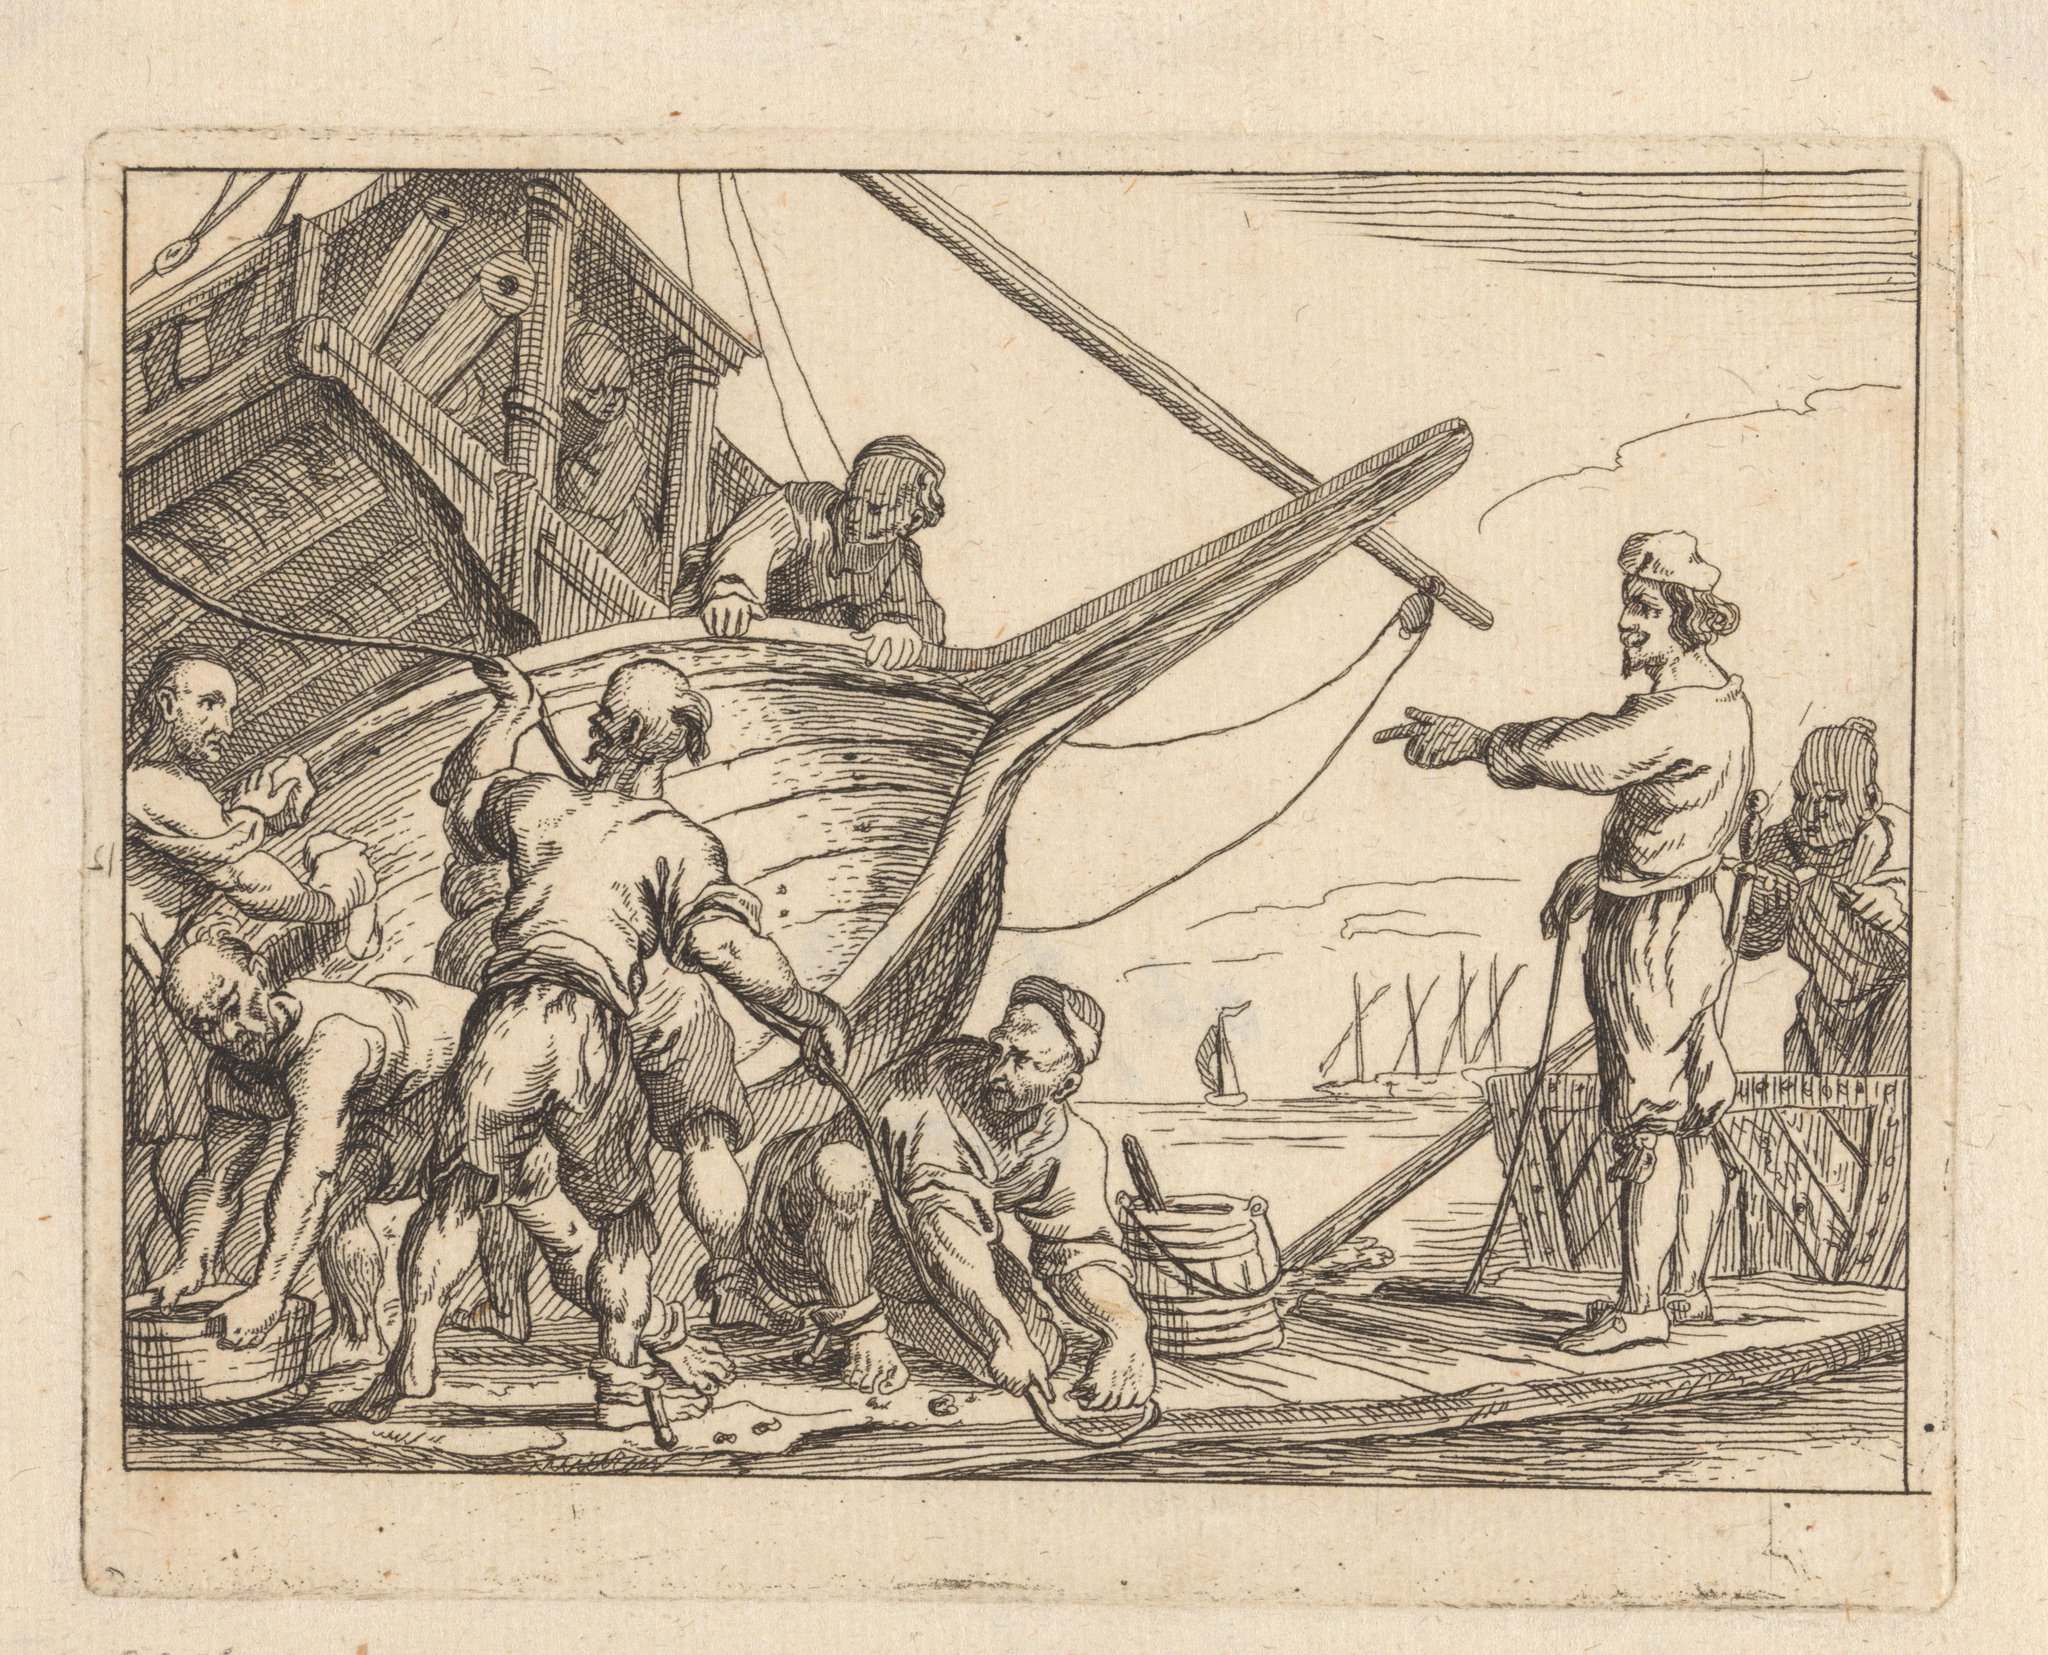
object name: print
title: Slaven aan het werk bij een schip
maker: m. schaep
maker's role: print maker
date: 1649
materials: paper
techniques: etching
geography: genoa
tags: harbour, trireme, galley (+ view ~ vehicle, ship, etc.), slavery; serfs and enslaved persons, seaman: sailor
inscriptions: collector's mark: Lugt 2228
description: Islamitische galeislaven zijn bezig een galei klaar te maken voor droogdok. Deze tot slaaf gemaakte mannen zijn als moslims te herkennen door het typerende kapsel (hoofd op een pluk na kaalgeschoren) dat zij verplicht waren te hebben. Een opzichter geeft aanwijzingen.